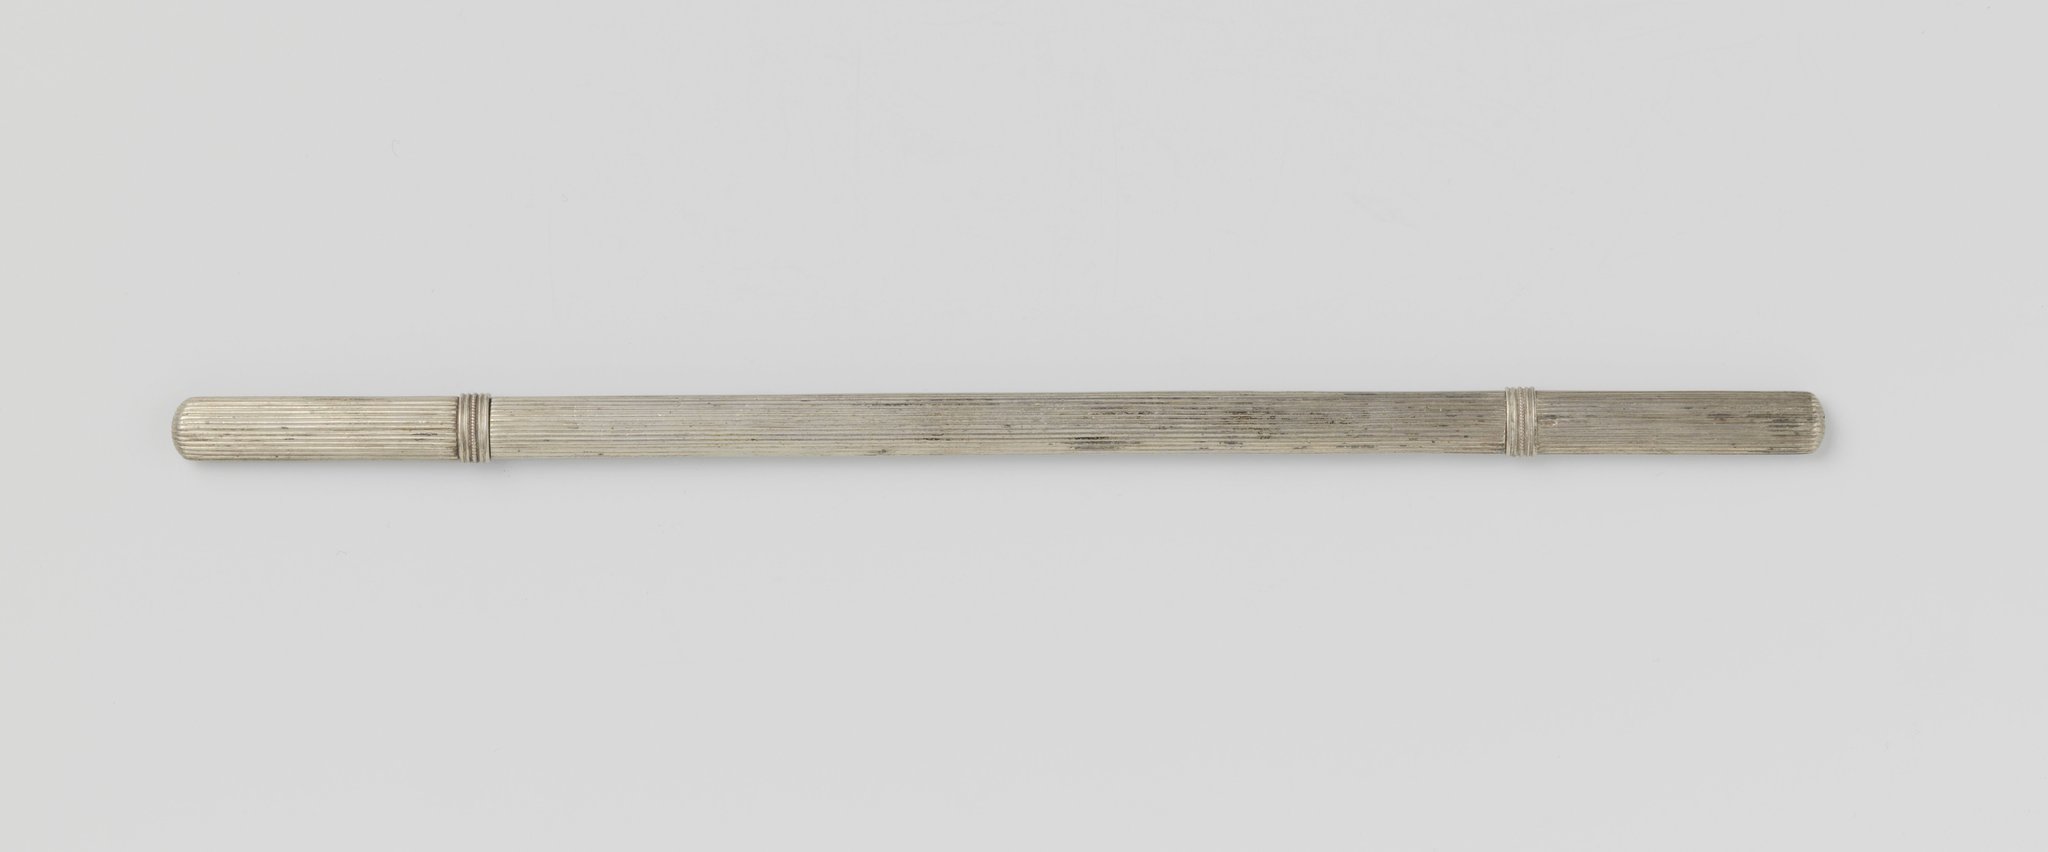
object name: handwerkgerei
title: Breikoker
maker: th.c. moot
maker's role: silversmith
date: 1812-1830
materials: silver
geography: utrecht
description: Breikoker met kokertje met haak van zilver. De haak ontbreekt.